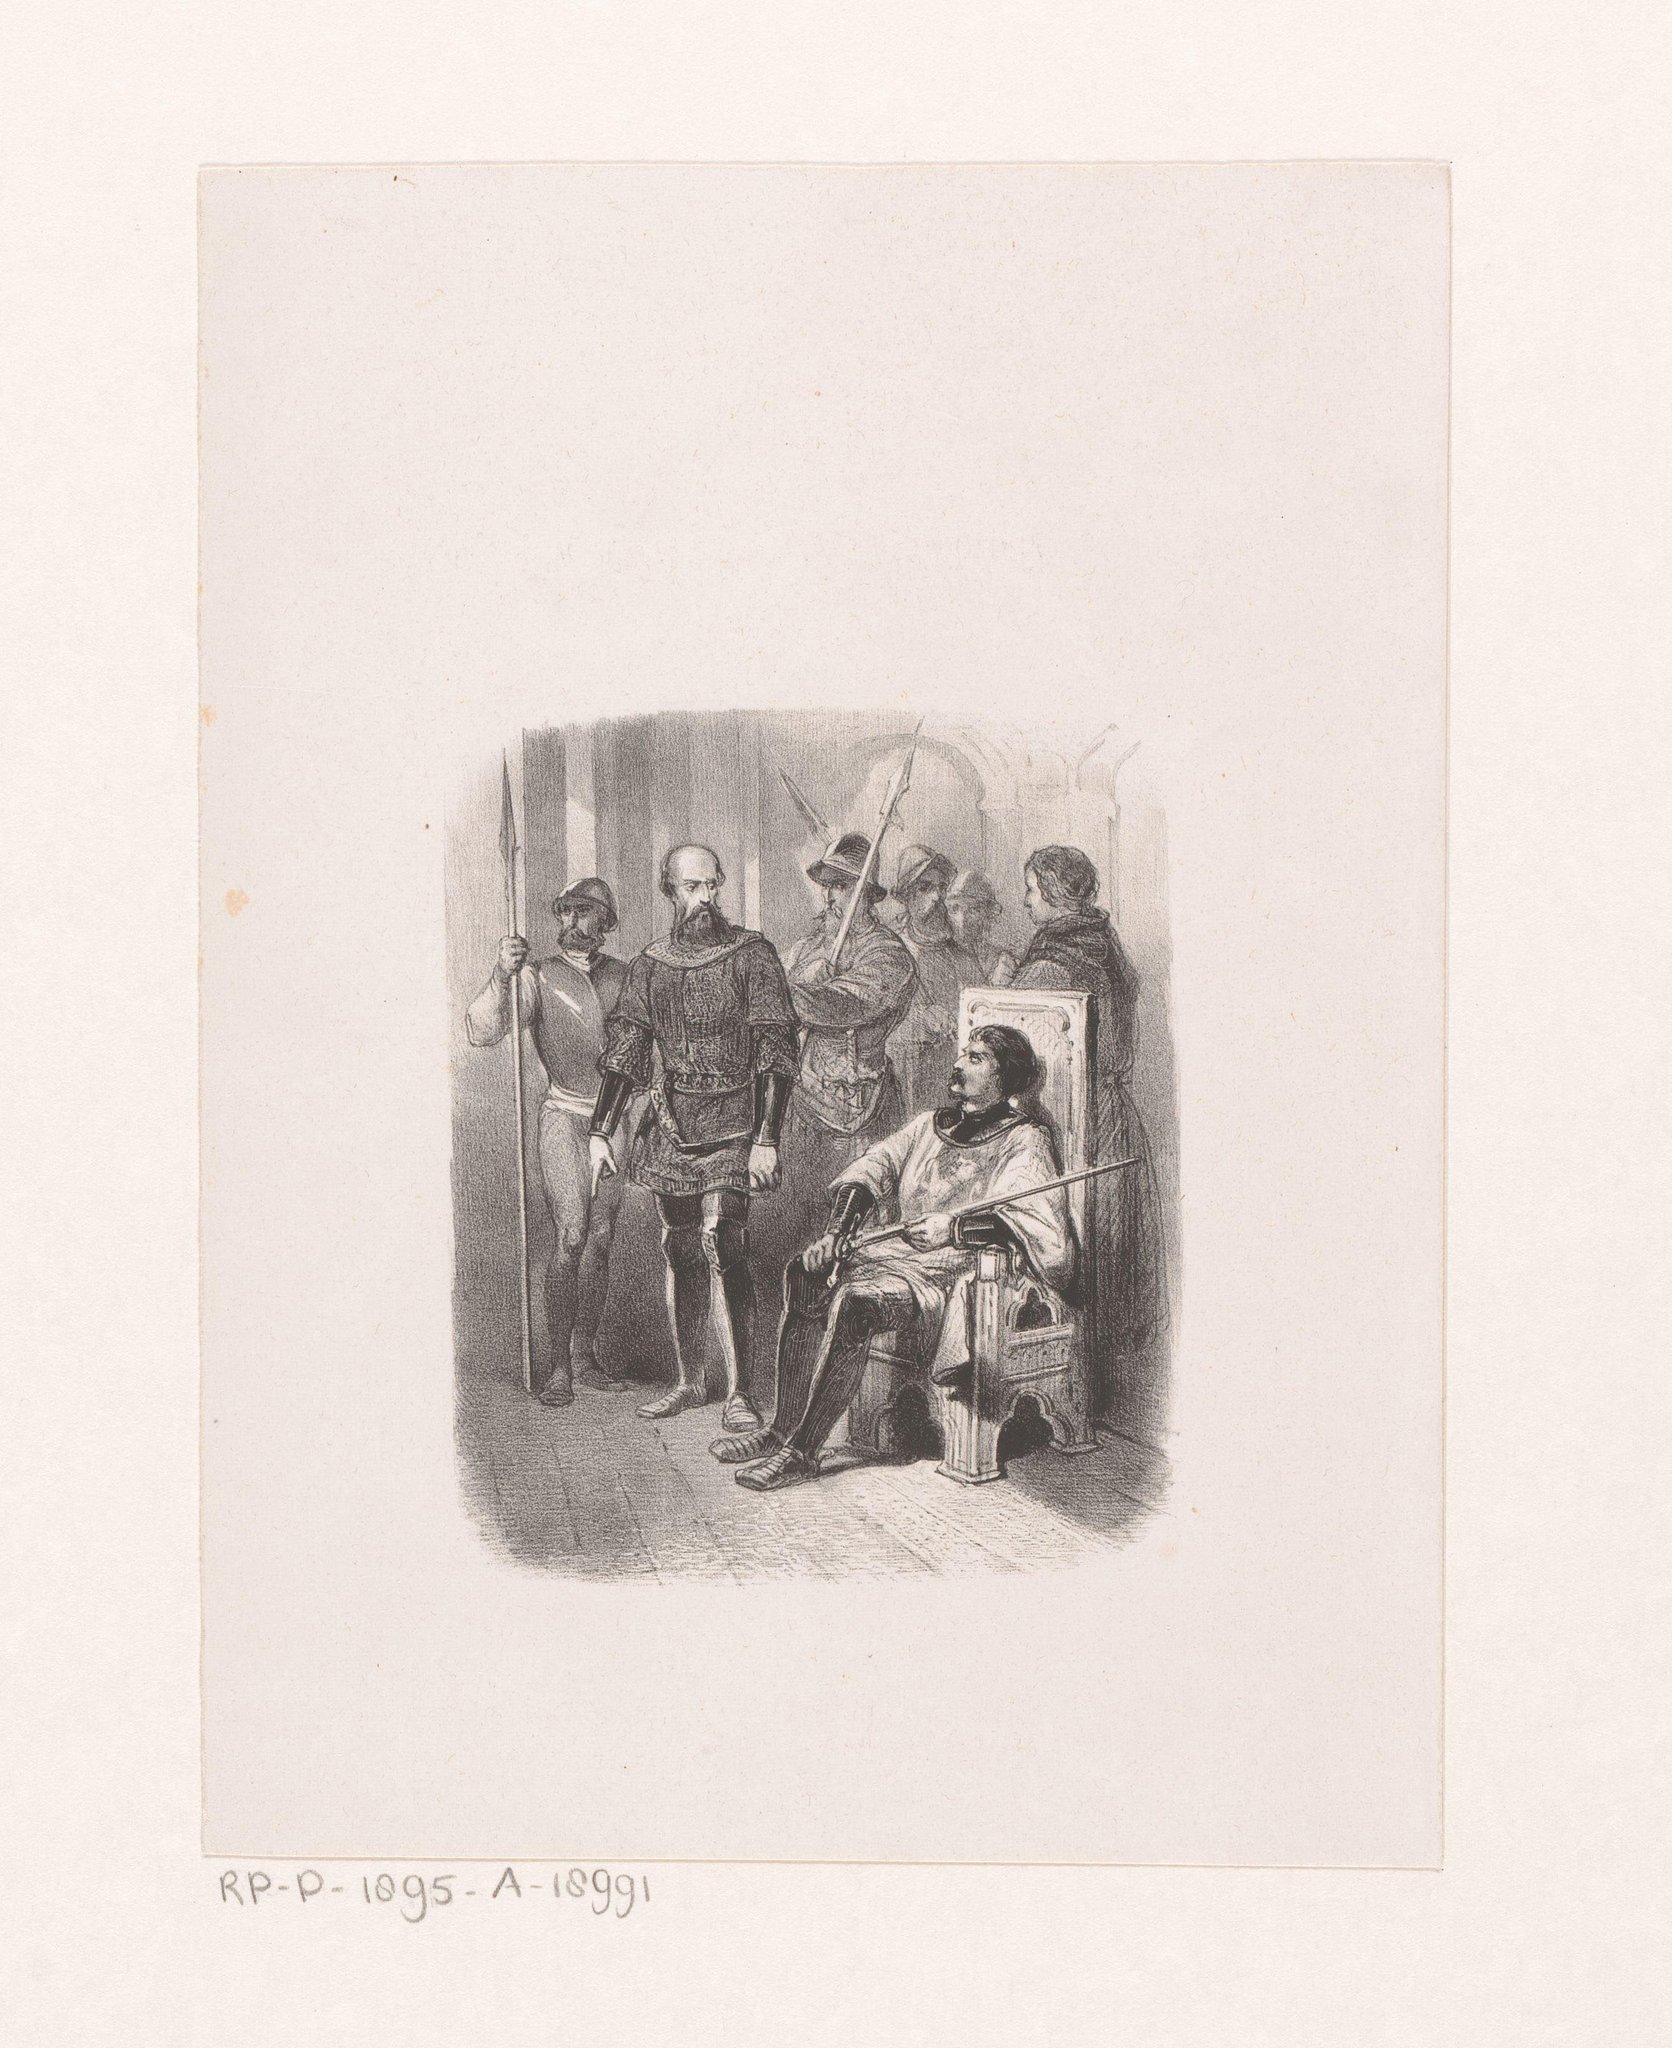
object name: print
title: Geharnaste mannen en monnik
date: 1824-1894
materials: paper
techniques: lithograph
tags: armour, monk(s), friar(s)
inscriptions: collector's mark: Lugt 2228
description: Een geharnaste man zit in een stoel met een zwaard in de rechterhand. Links staat een eveneens geharnaste man bewaakt door bewapende mannen. Rechts achter de stoel staat een monnik.